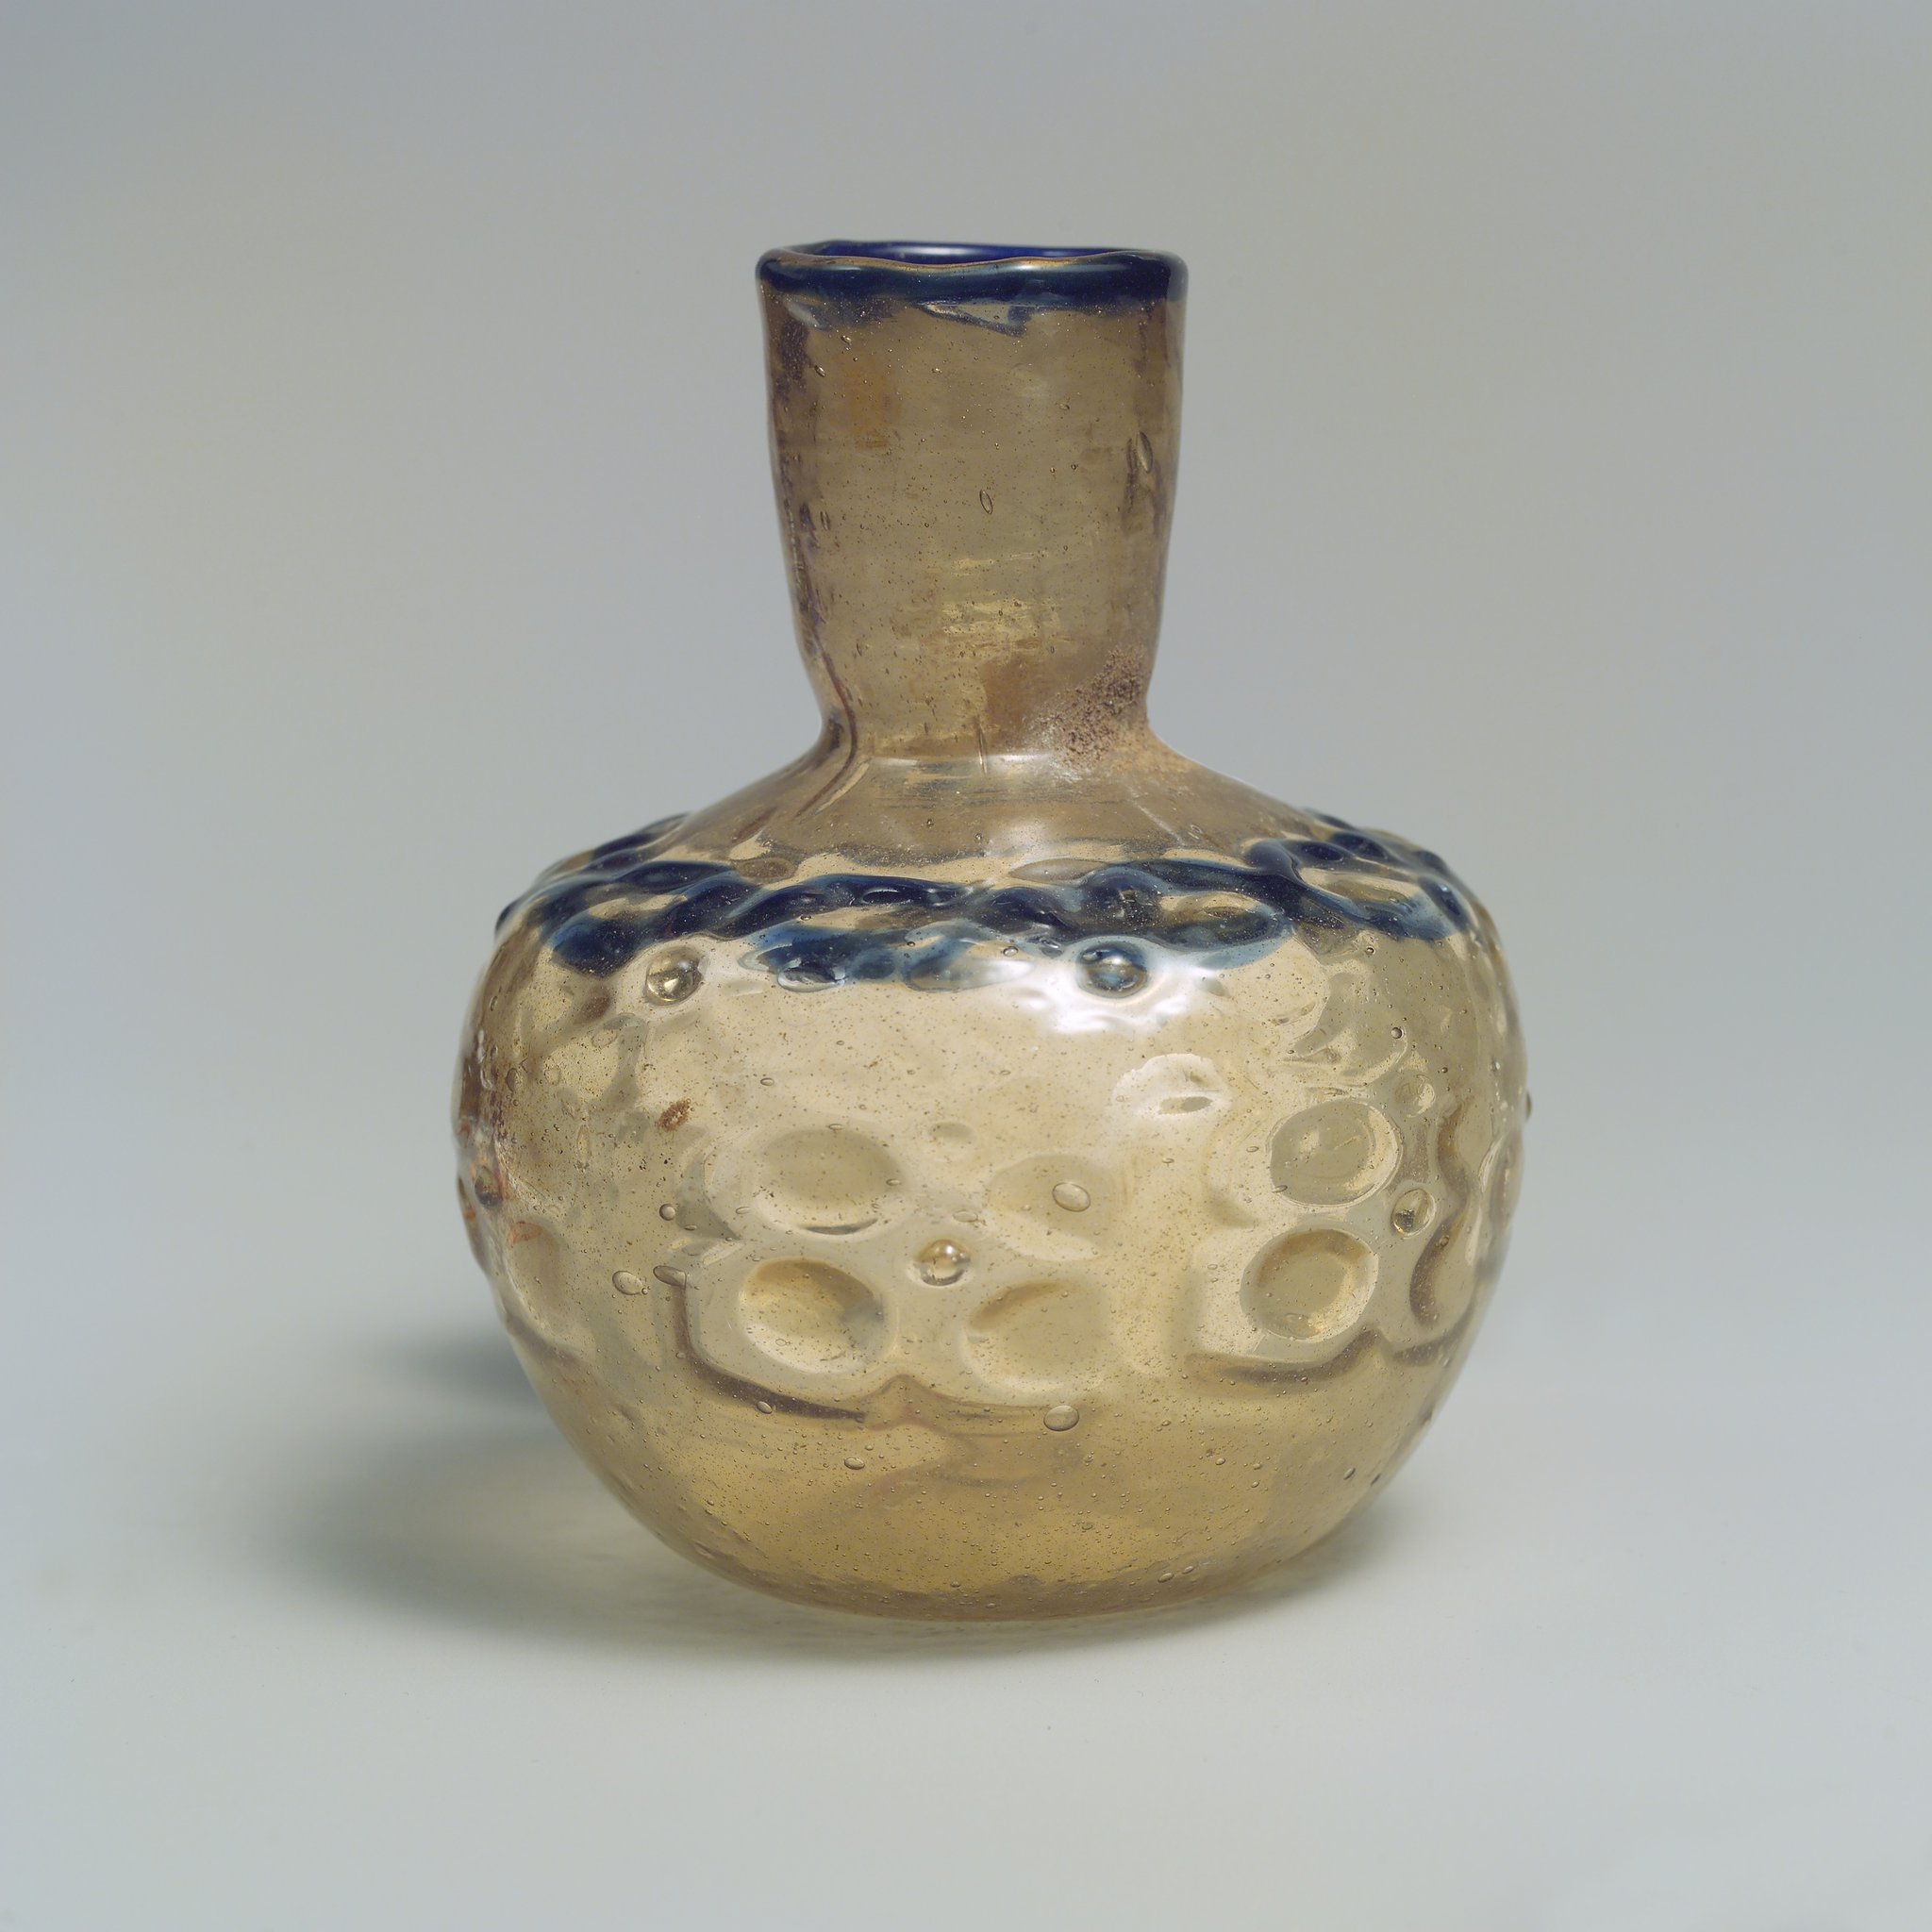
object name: bottle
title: Short-Necked bottle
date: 1101-1300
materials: glass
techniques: glassblowing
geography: iran